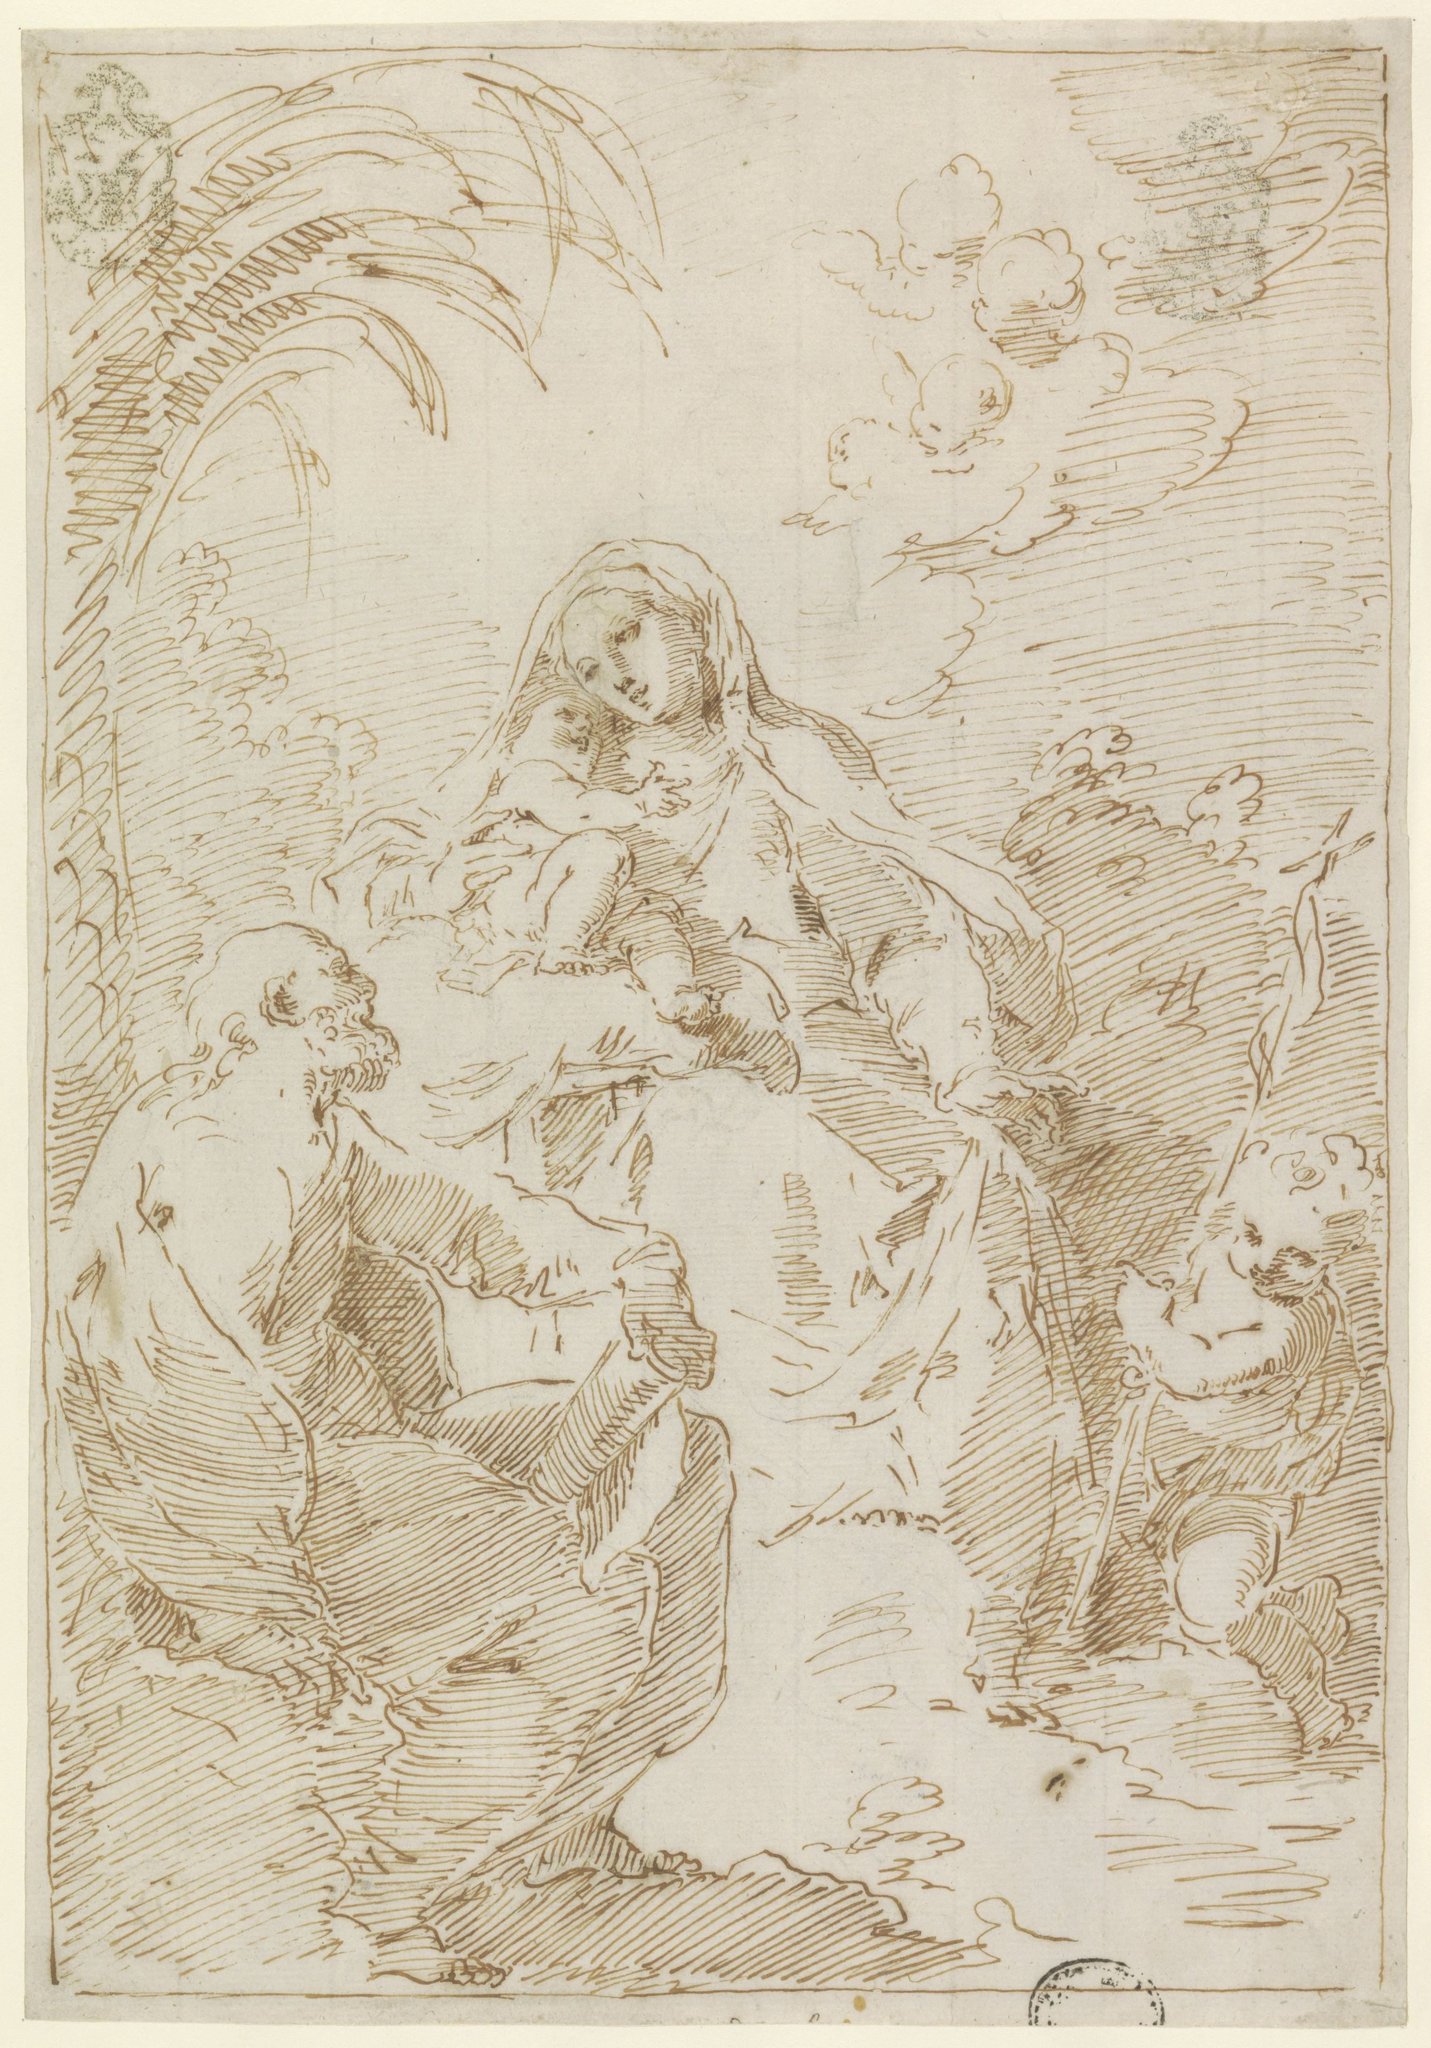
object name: drawing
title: De Heilige Familie met de kleine Johannes de Doper, zittend onder een palmboom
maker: francesco fontebasso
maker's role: draughtsman, painter, print maker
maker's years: 1707-1769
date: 1719-1769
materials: ink, paper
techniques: pen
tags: holy family with john the baptist (as child)